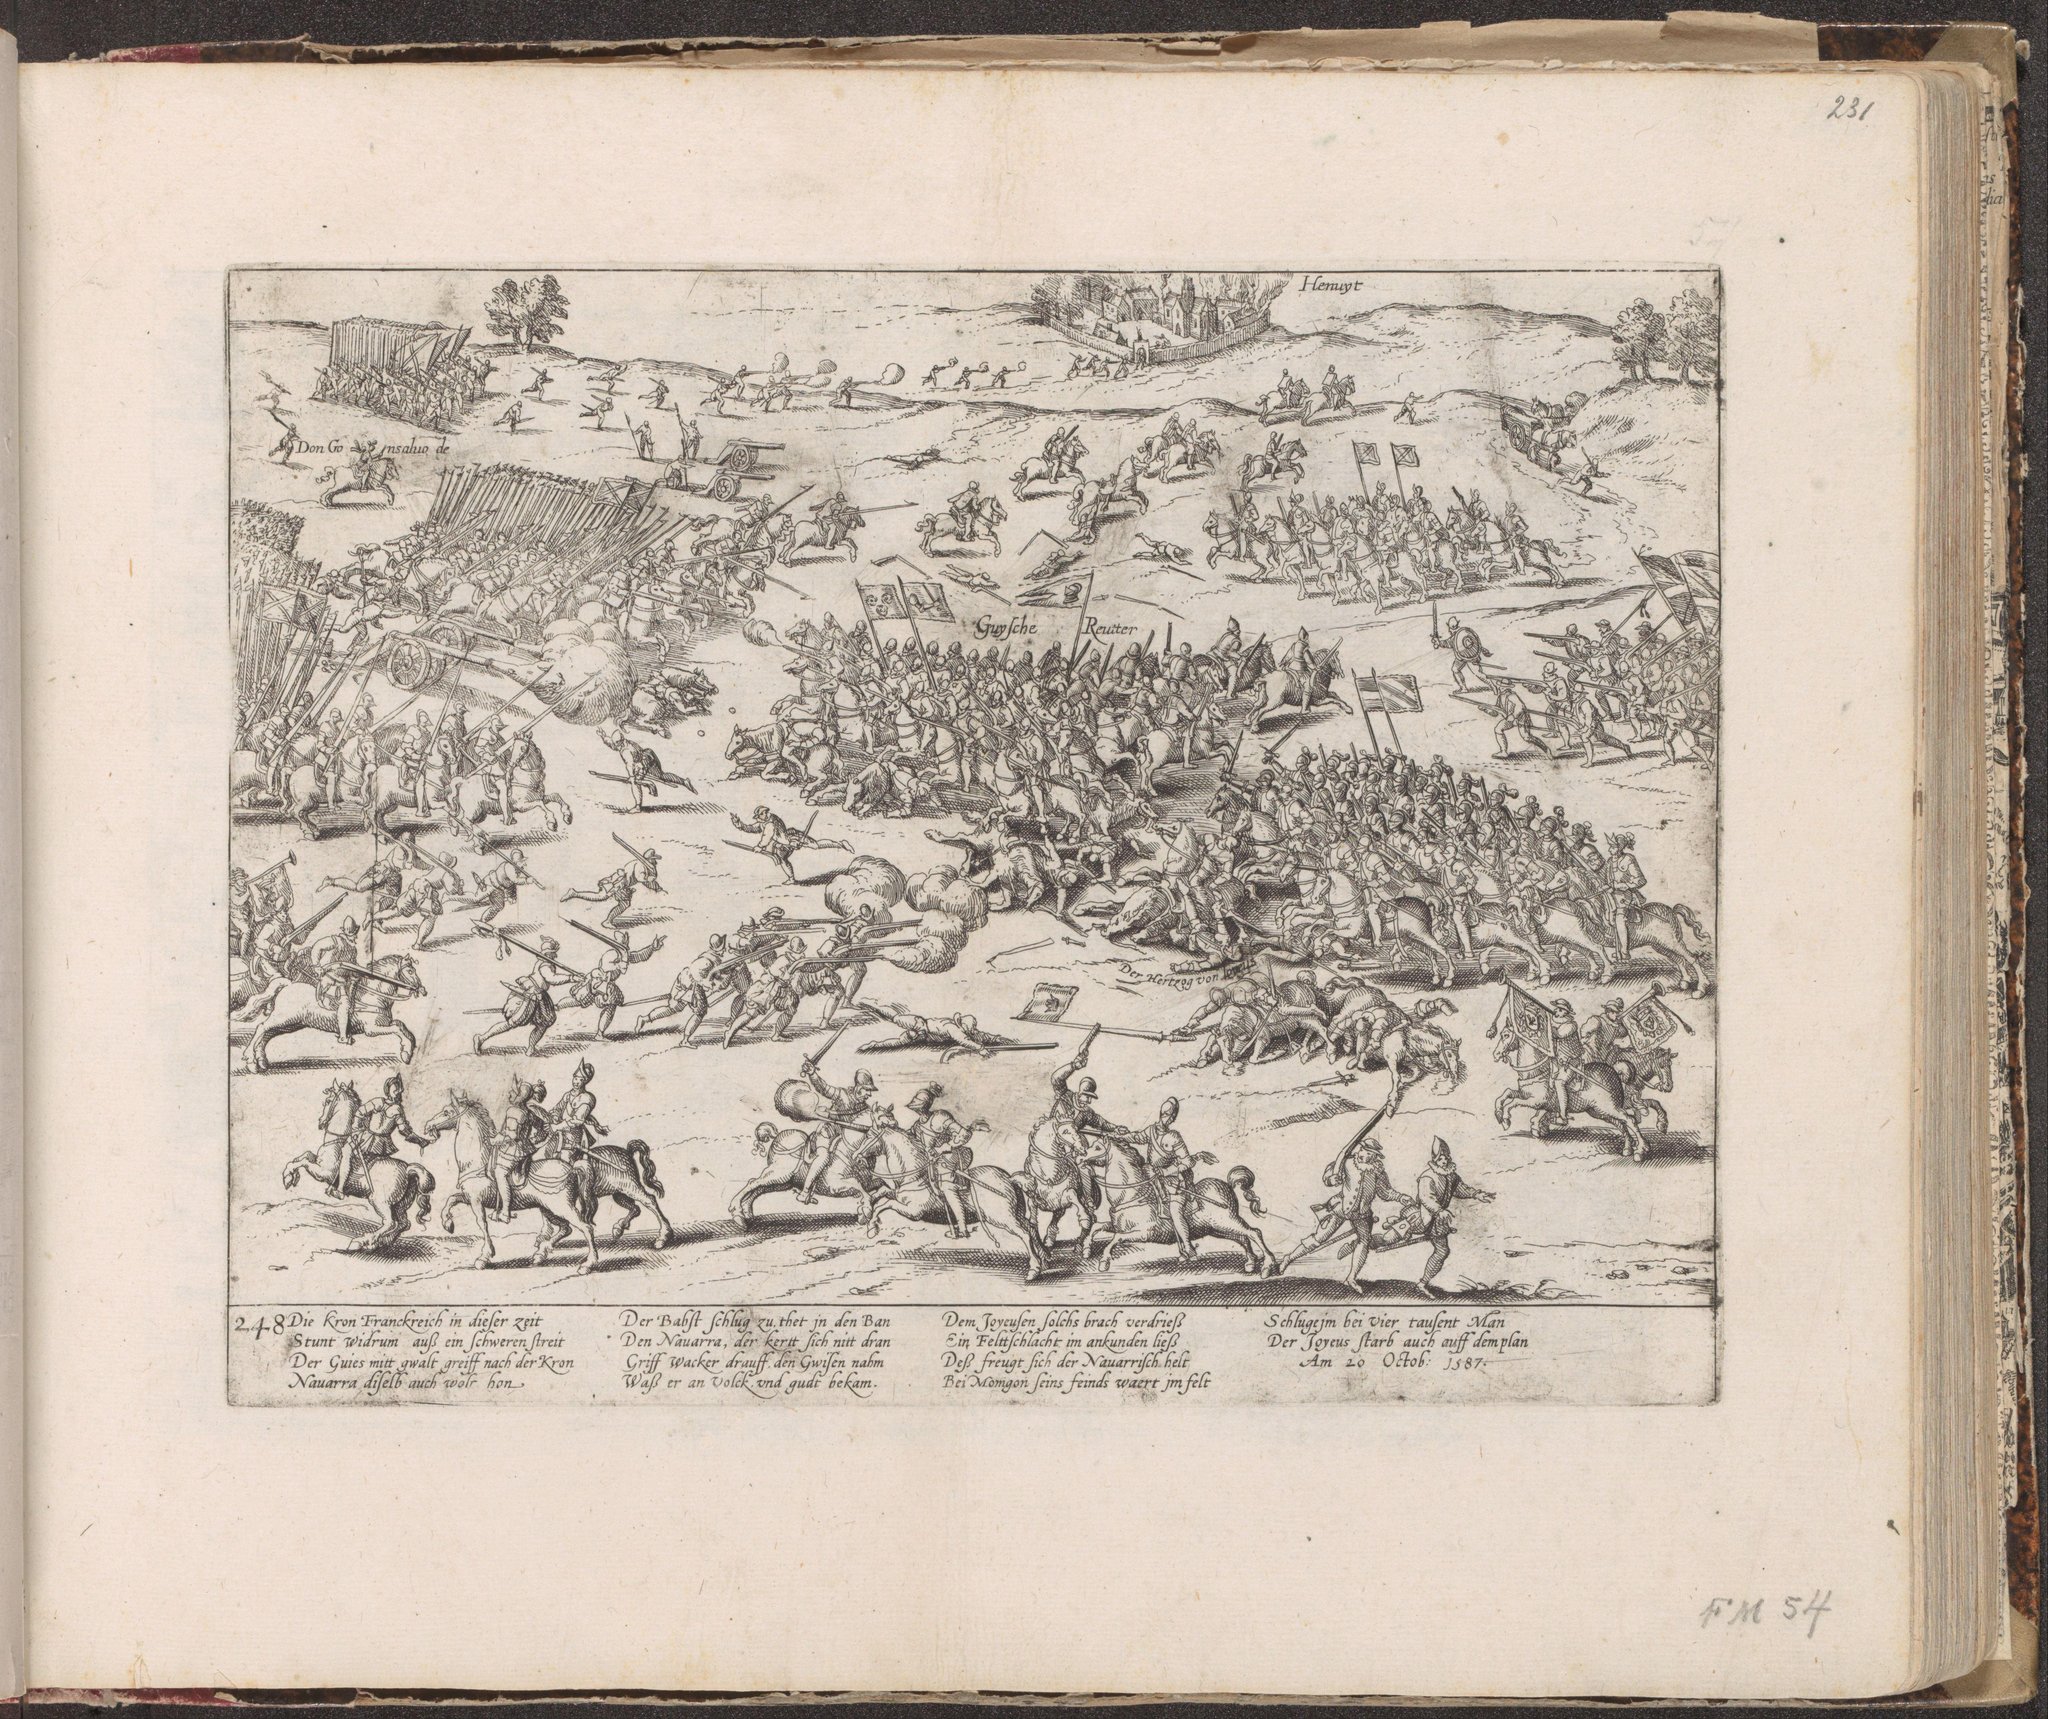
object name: album leaf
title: Serie 4: Franse, Duitse en Engelse Gebeurtenissen, 1576-1610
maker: frans hogenberg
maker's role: print maker, publisher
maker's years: 1538-1590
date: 1589-1593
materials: paper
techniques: etching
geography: cologne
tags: paris, hendrik iv (koning van frankrijk en navarra), battle (+ land forces)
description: Overwinning van koning Hendrik IV van Navarra bij Montjoie, 20 oktober 1587. Gezicht op de veldslag. Met onderschrift van 14 regels in het Duits. Linksonder genummerd: 248. De prent maakt deel uit van een album.